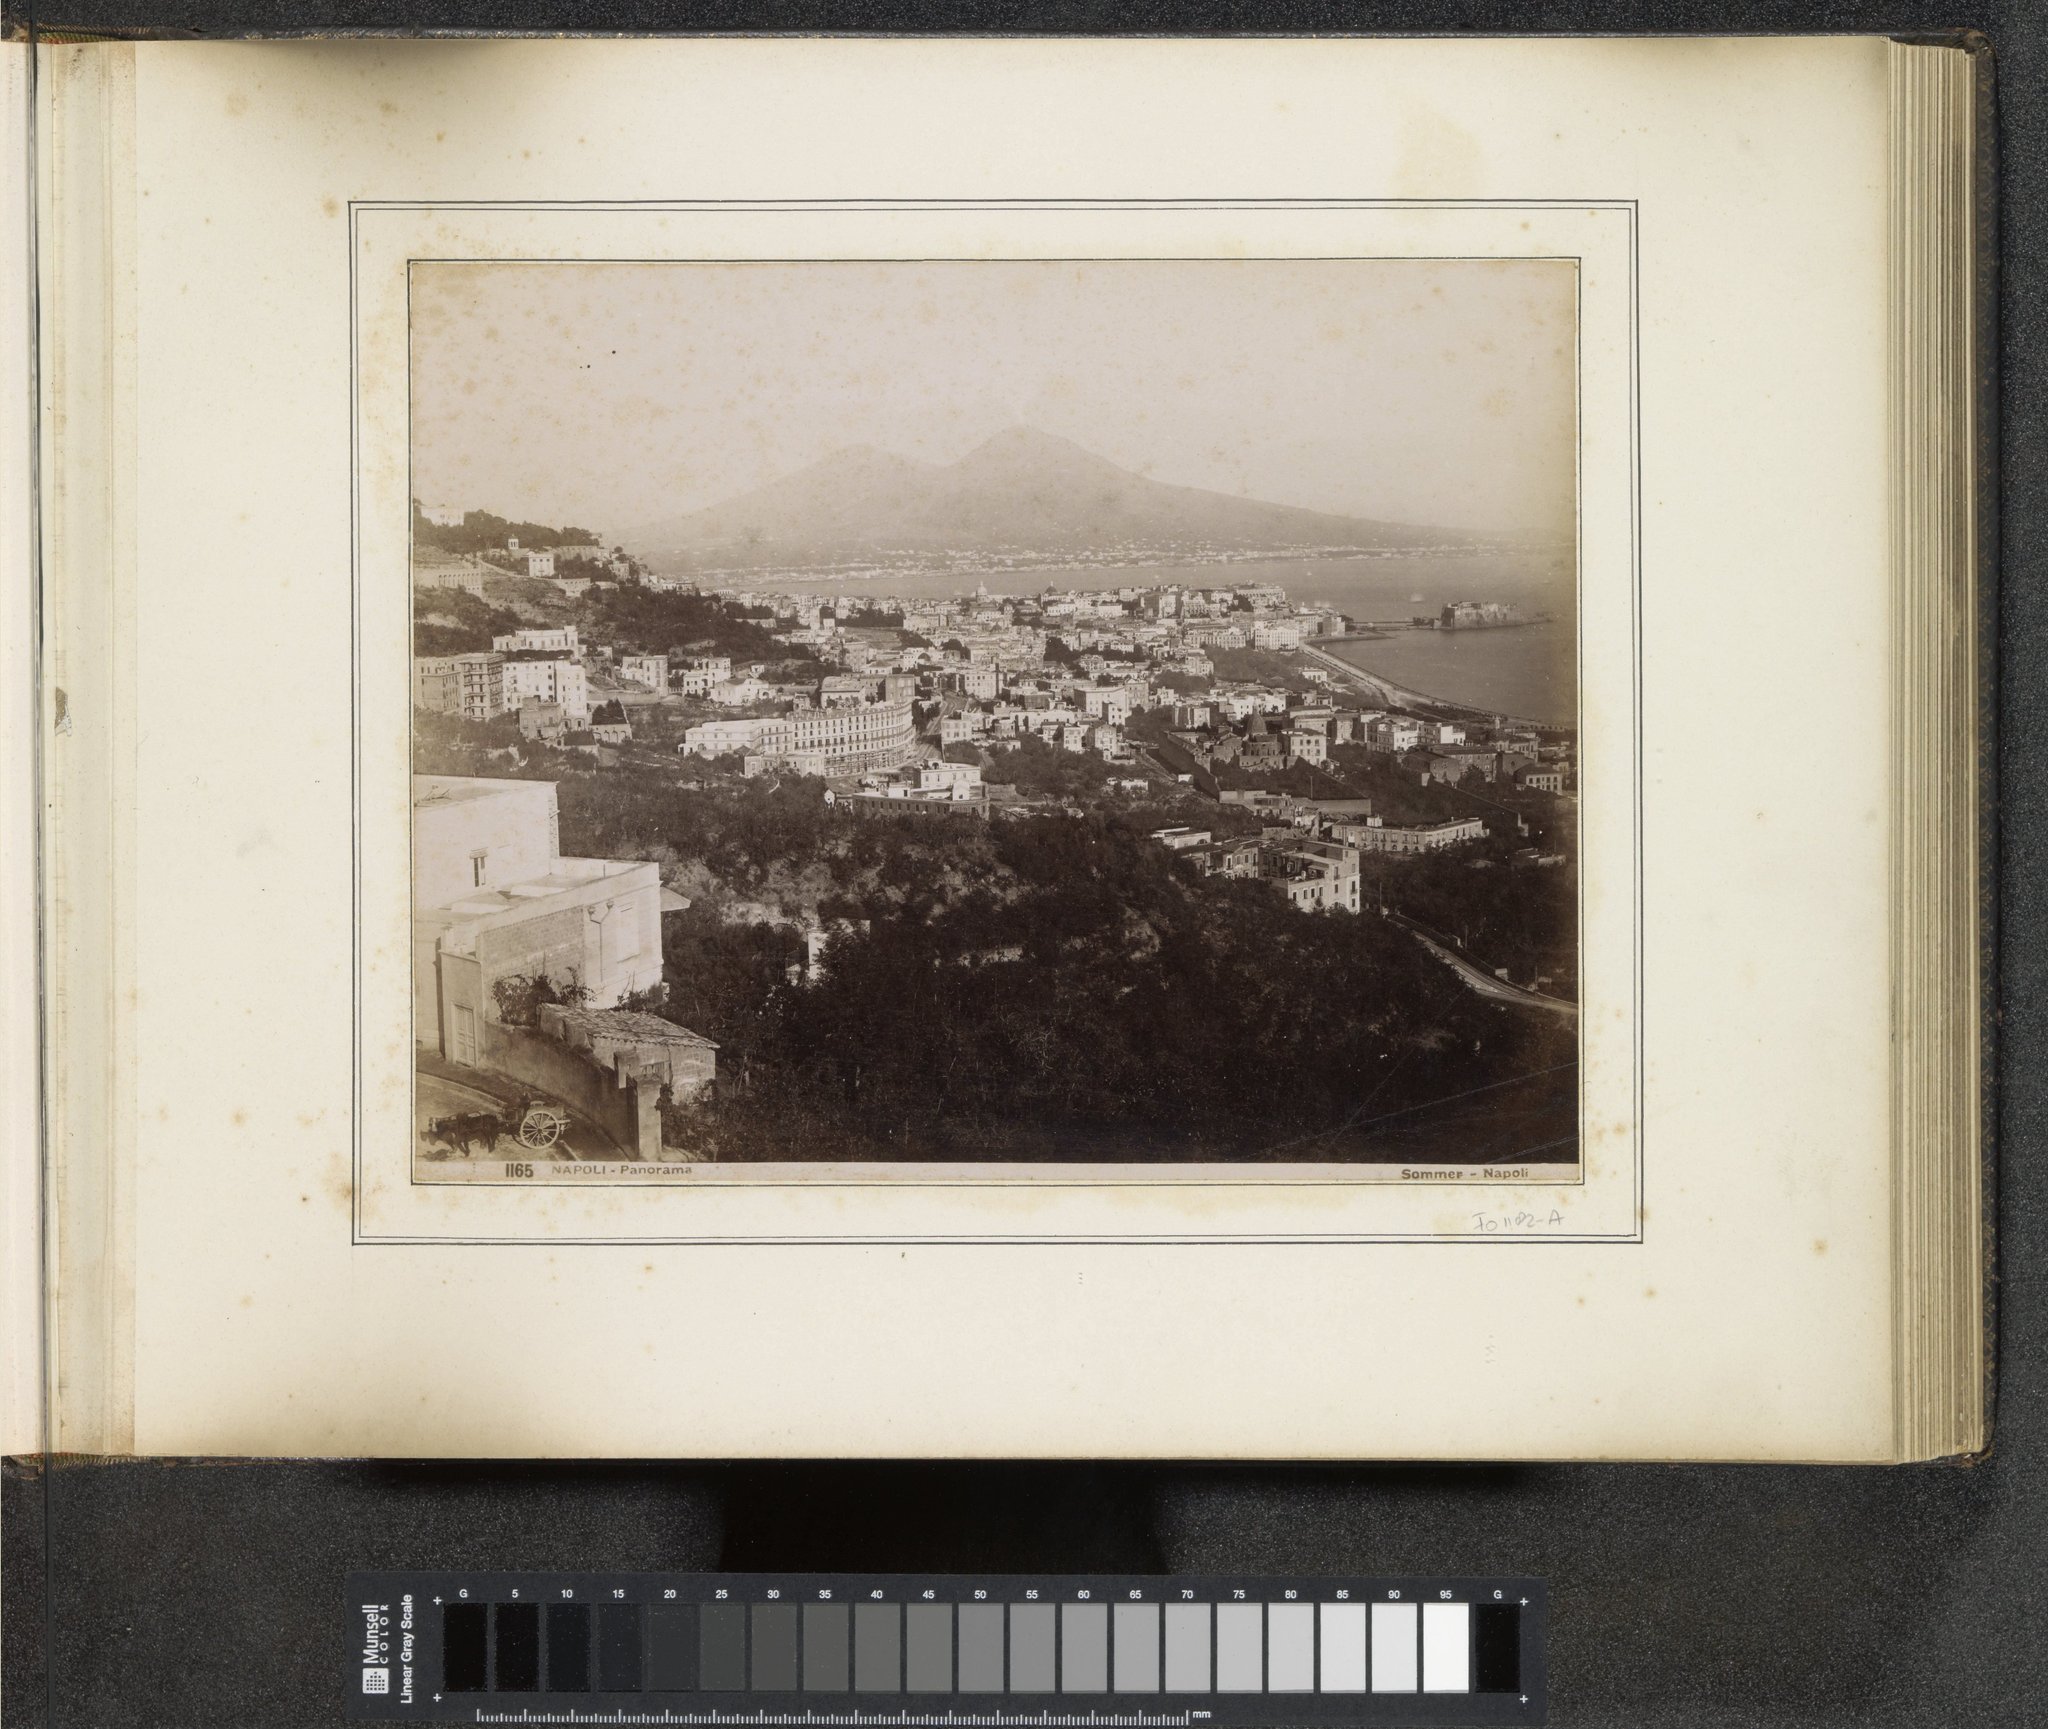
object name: photograph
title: Gezicht op Napels met aan de horizon de Vesuvius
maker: giorgio sommer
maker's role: fotograaf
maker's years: 1834-1914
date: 1860-1890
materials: paper, photographic support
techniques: albumen print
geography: naples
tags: volcano, prospect of city, town panorama, silhouette of city, naples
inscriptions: negative number: ‘1165’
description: Onderdeel van Reisalbum met foto's van bezienswaardigheden in Italië en aan de Franse Rivièra (deel II).